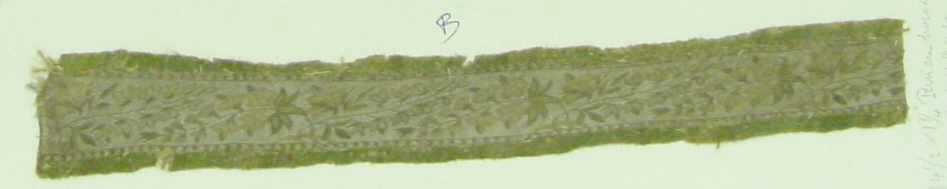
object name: textile fragment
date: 1601-1633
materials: metal thread, silk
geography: iran